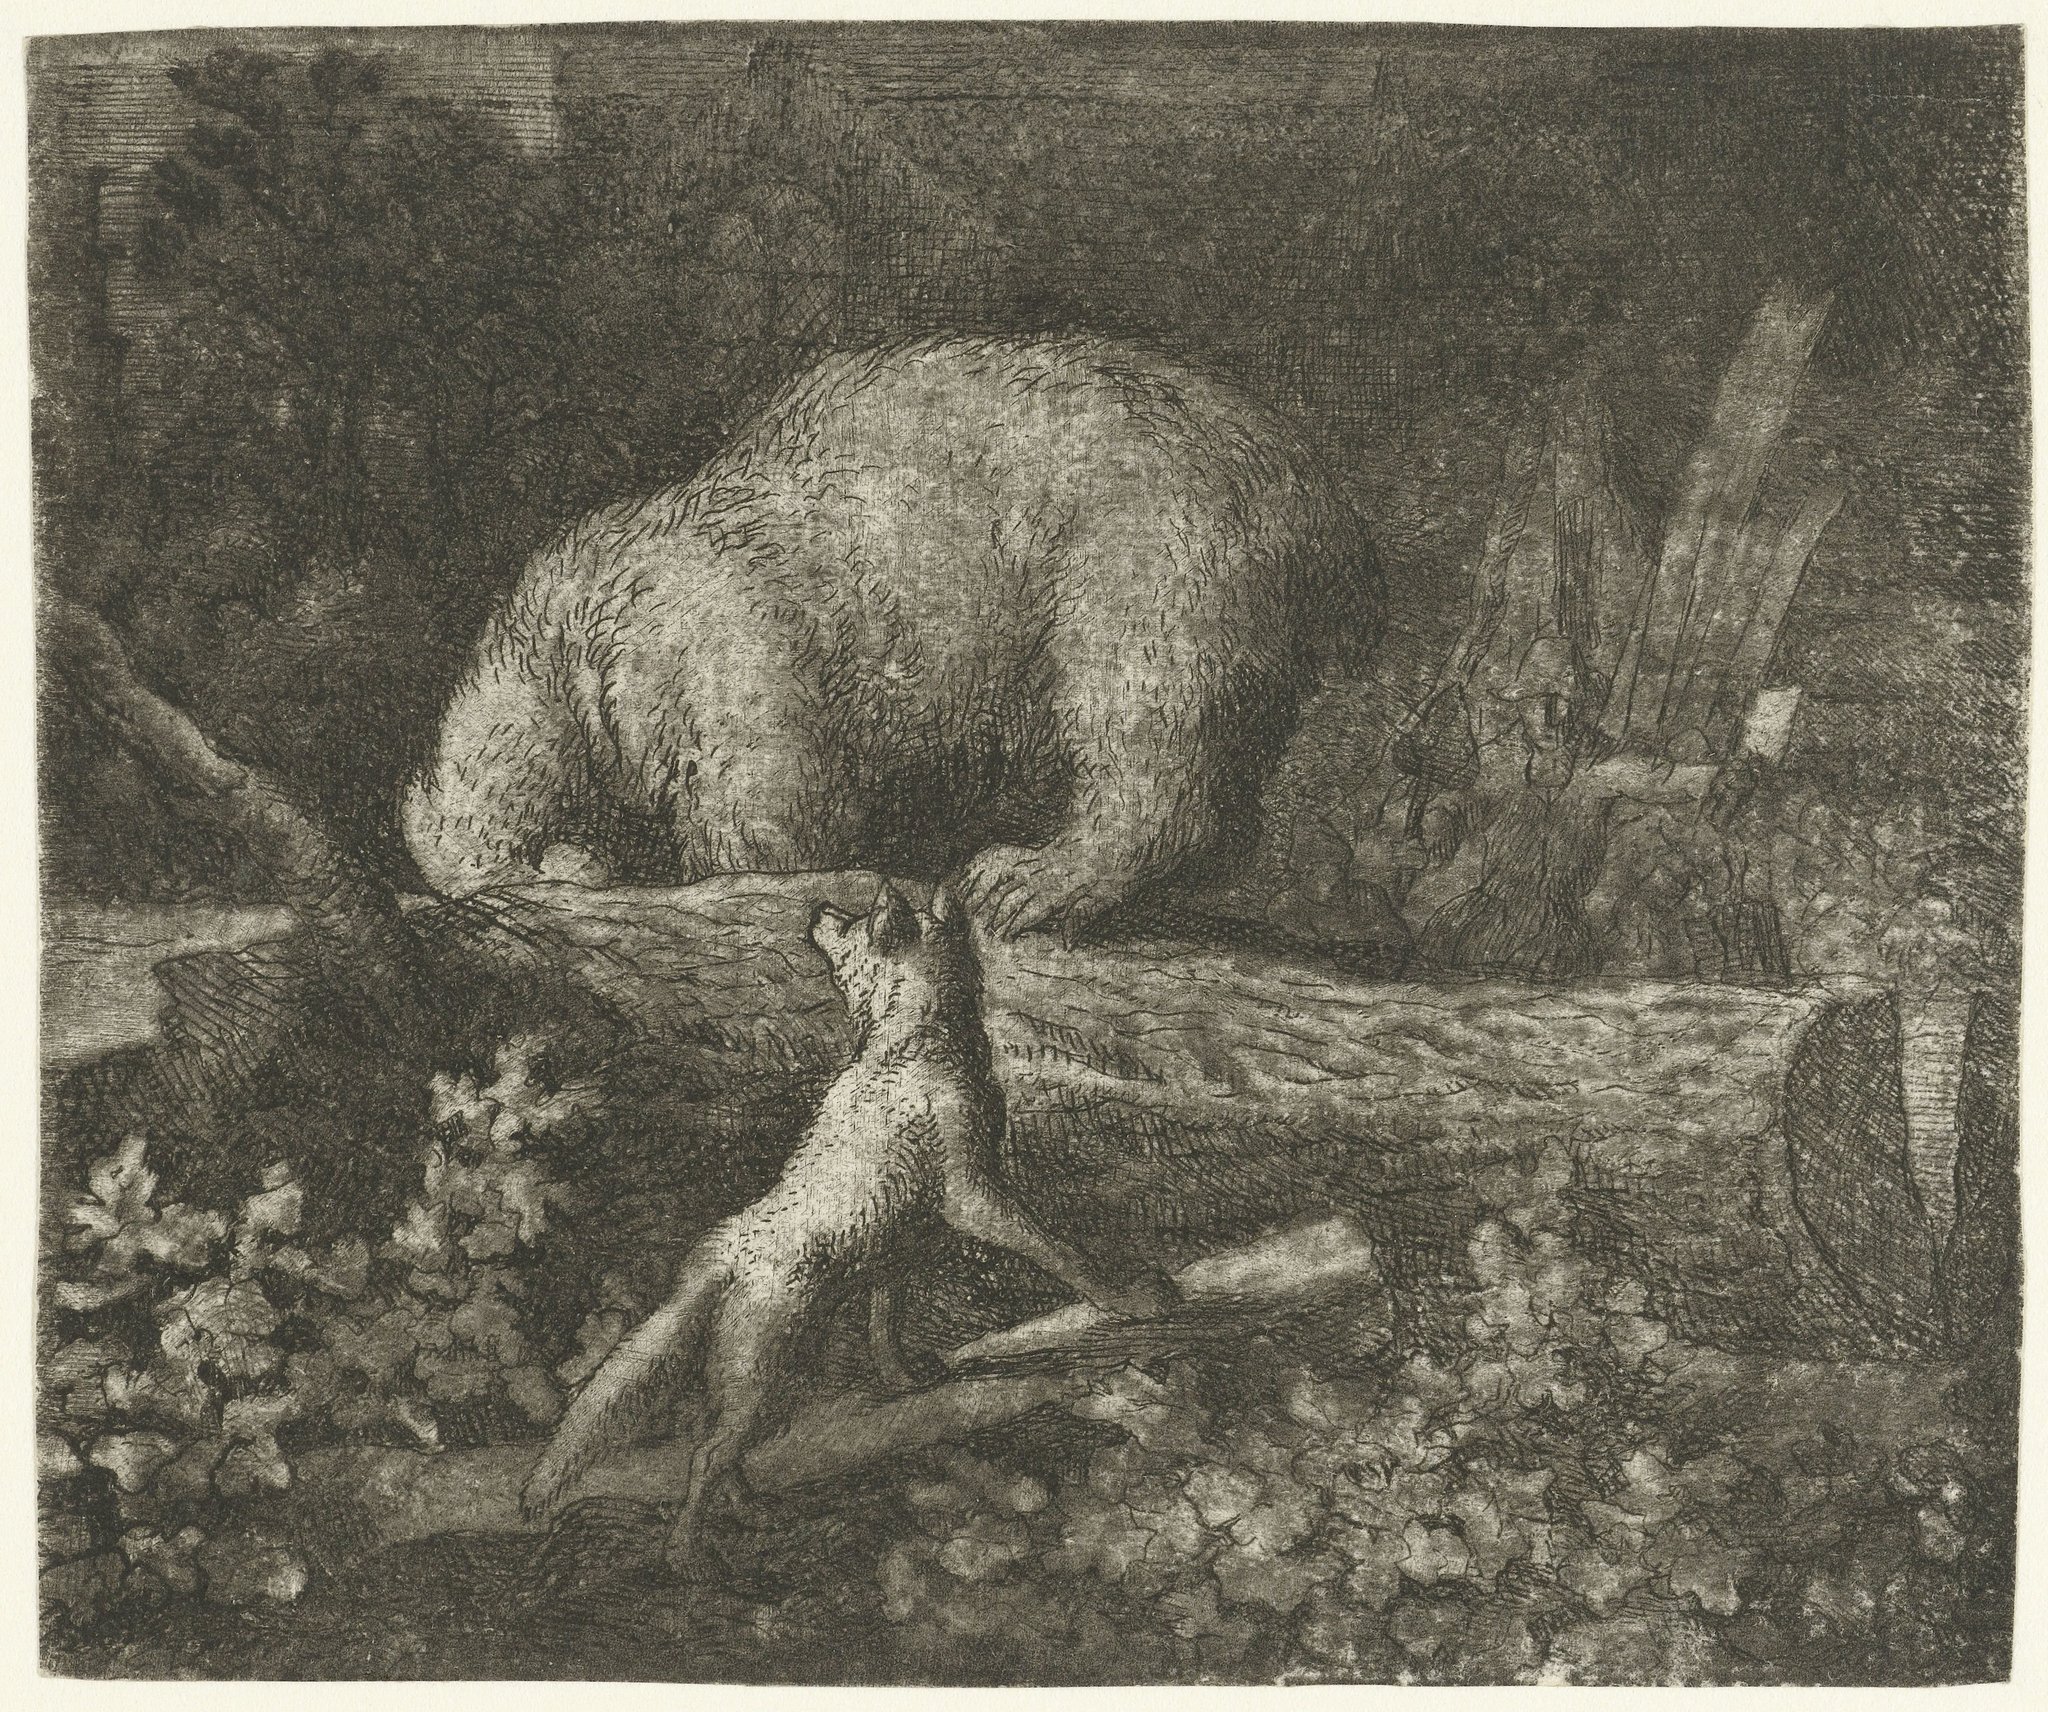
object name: print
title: Reinaert de vos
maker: allaert van everdingen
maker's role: draughtsman, painter, print maker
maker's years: 1621-1675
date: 1665-1675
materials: paper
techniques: etching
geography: netherlands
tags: fable of reynard the fox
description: Reinaert de vos verwijdert de wig, waardoor Bruun de beer met zijn kop in de boomstam vast komt te zitten. Op de achtergrond zijn de boeren uit het dorp in aantocht.